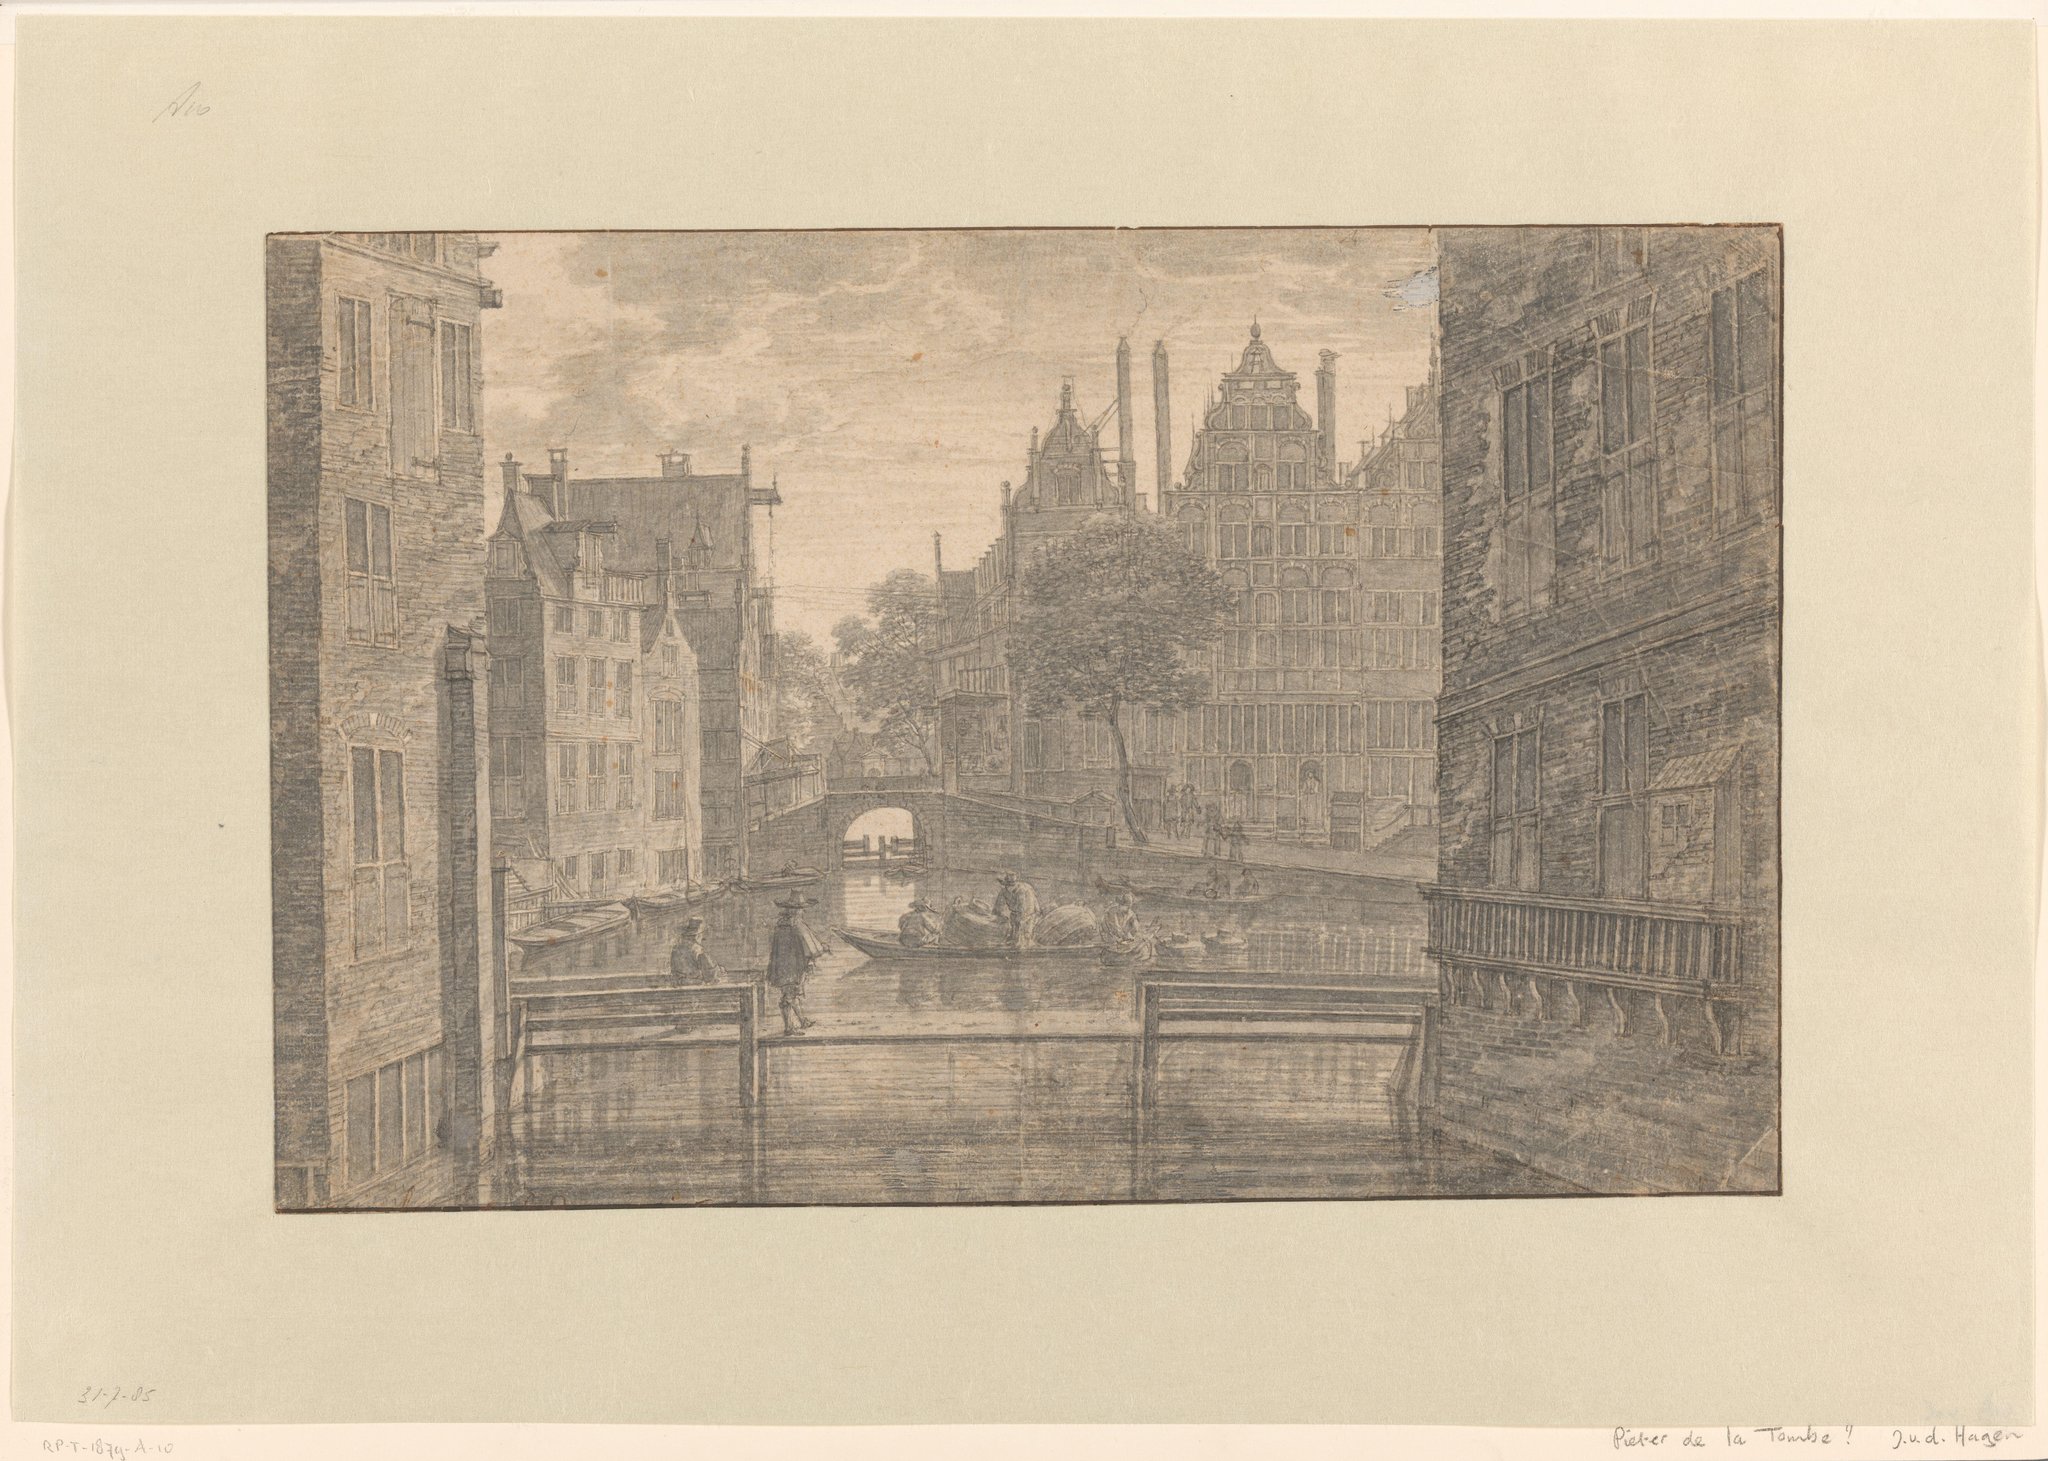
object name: drawing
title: Gezicht van de Osjessluis naar de Grimnessesluis in Amsterdam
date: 1661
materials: chalk, paper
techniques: brush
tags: canals, waters (in city)